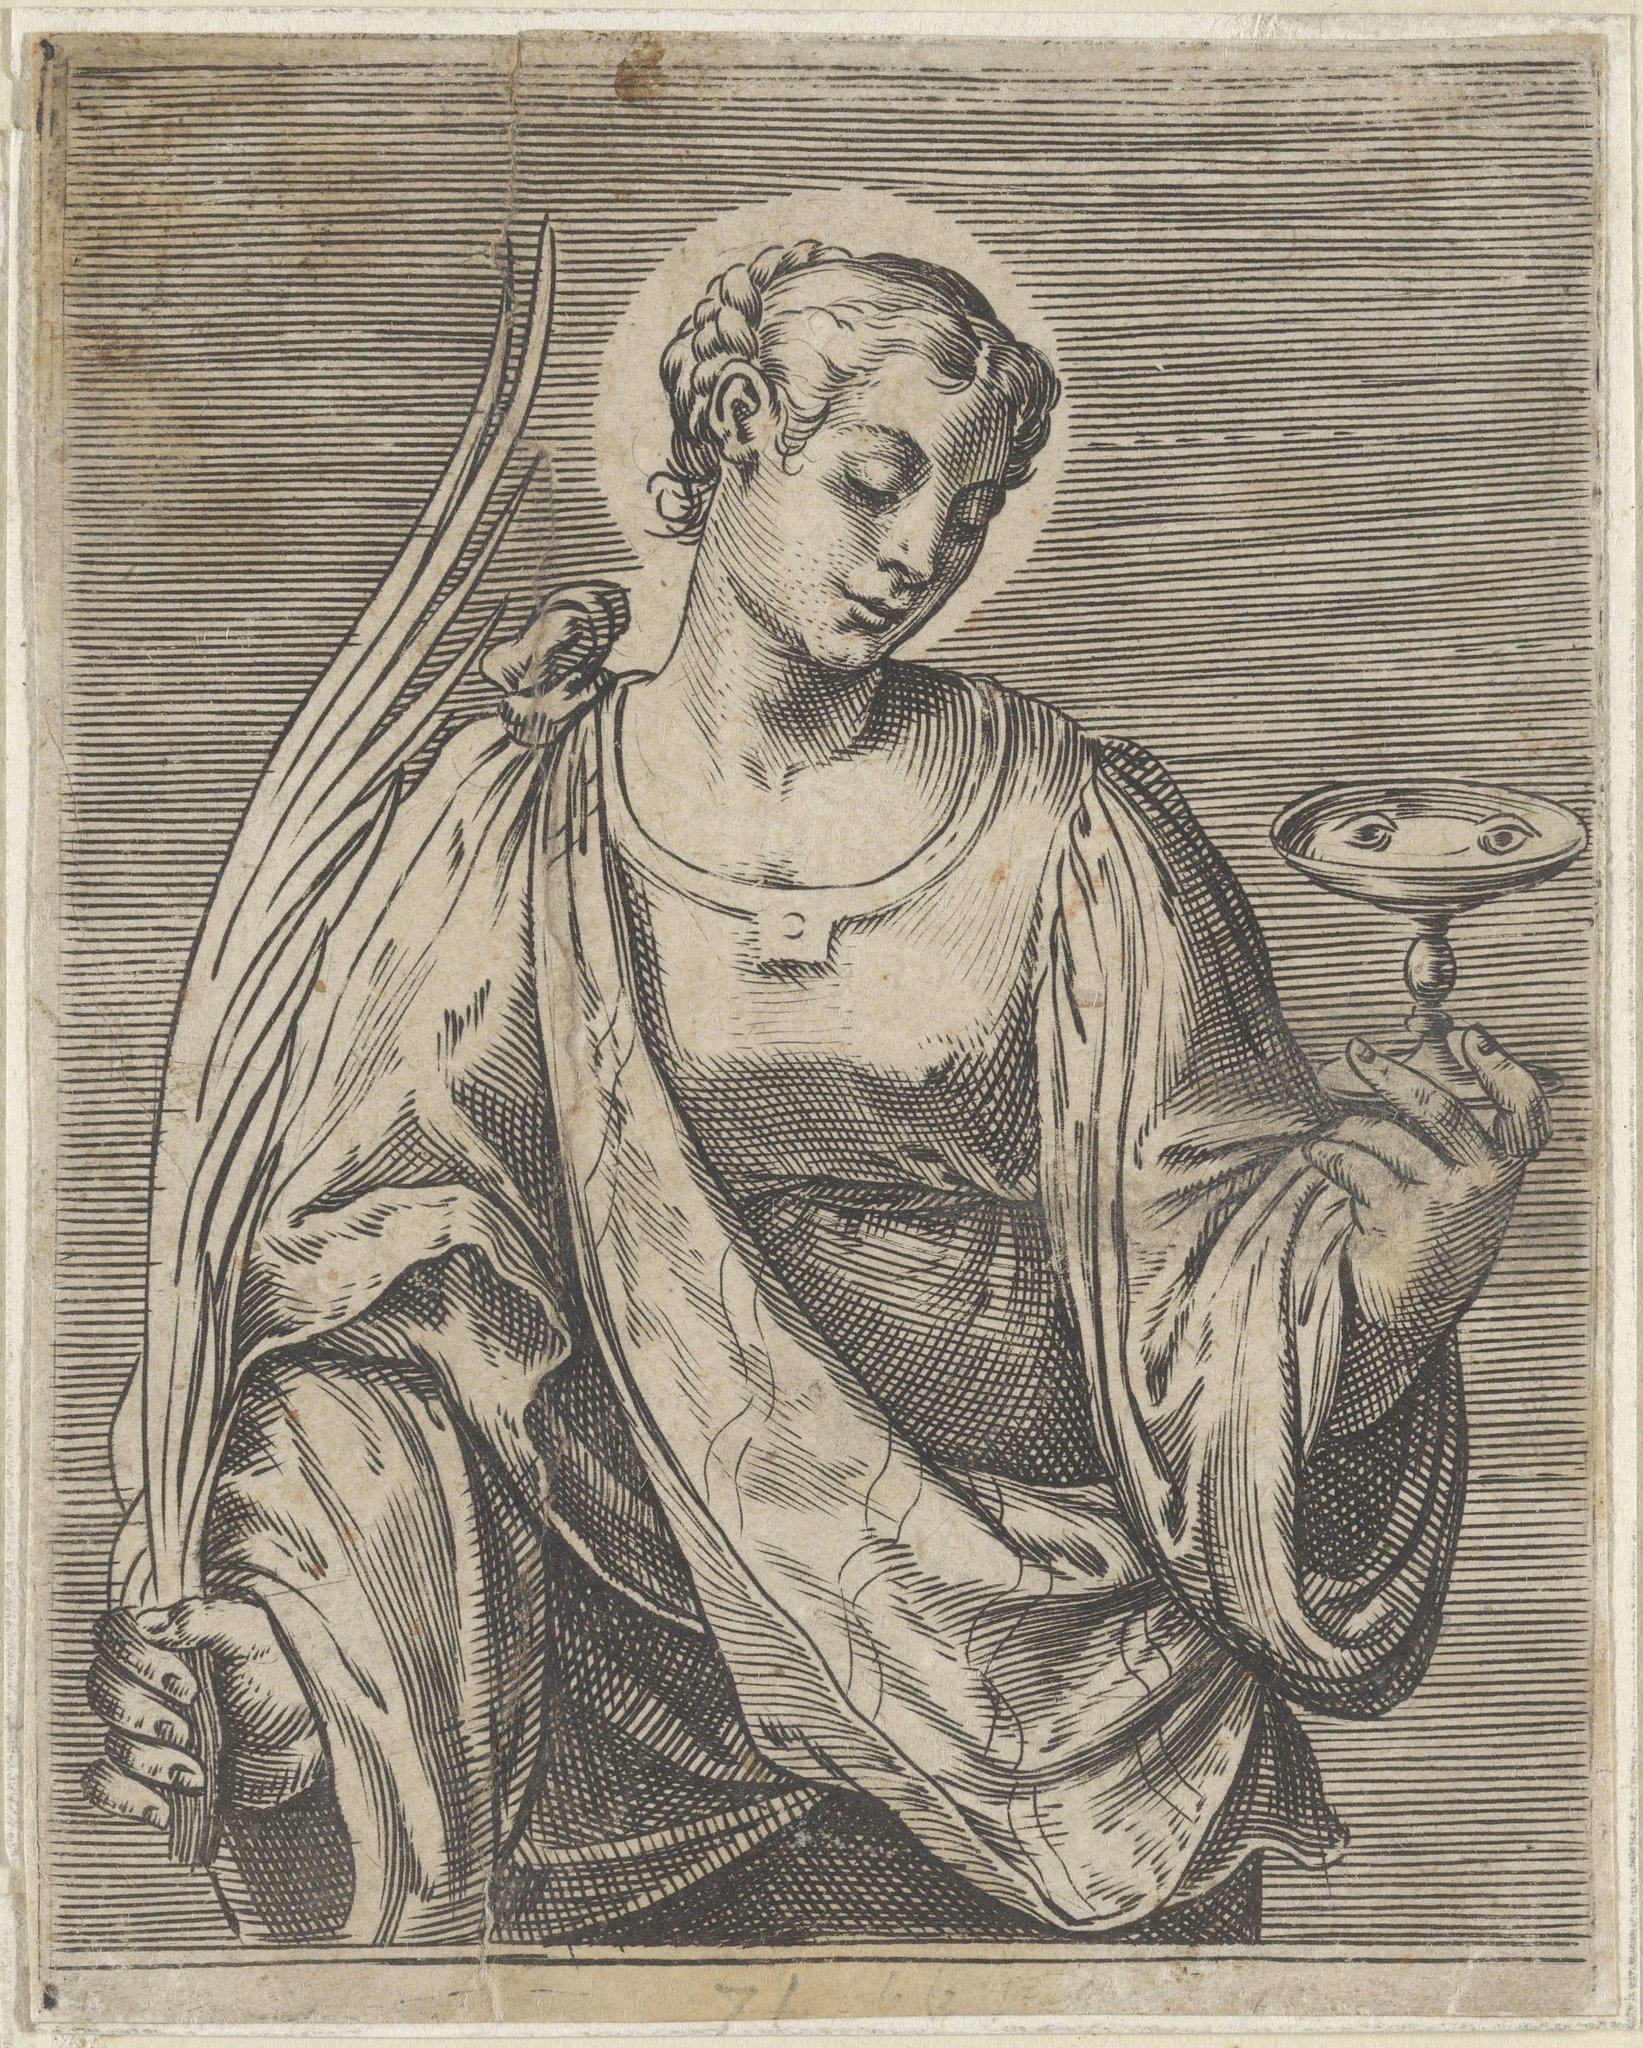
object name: print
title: Heilige Lucia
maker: agostino carracci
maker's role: draughtsman, painter, print maker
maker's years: 1557-1602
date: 1581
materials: paper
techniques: engraving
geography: italy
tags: the virgin martyr lucy (lucia) of syracuse; possible attributes: dagger or sword (in neck), eyes, flames at feet, lamp, ox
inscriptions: collector's mark: Lugt 240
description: De martelares Lucia uit Syracuse. In haar handen houdt Lucia een palmtak en een schaal met twee ogen.